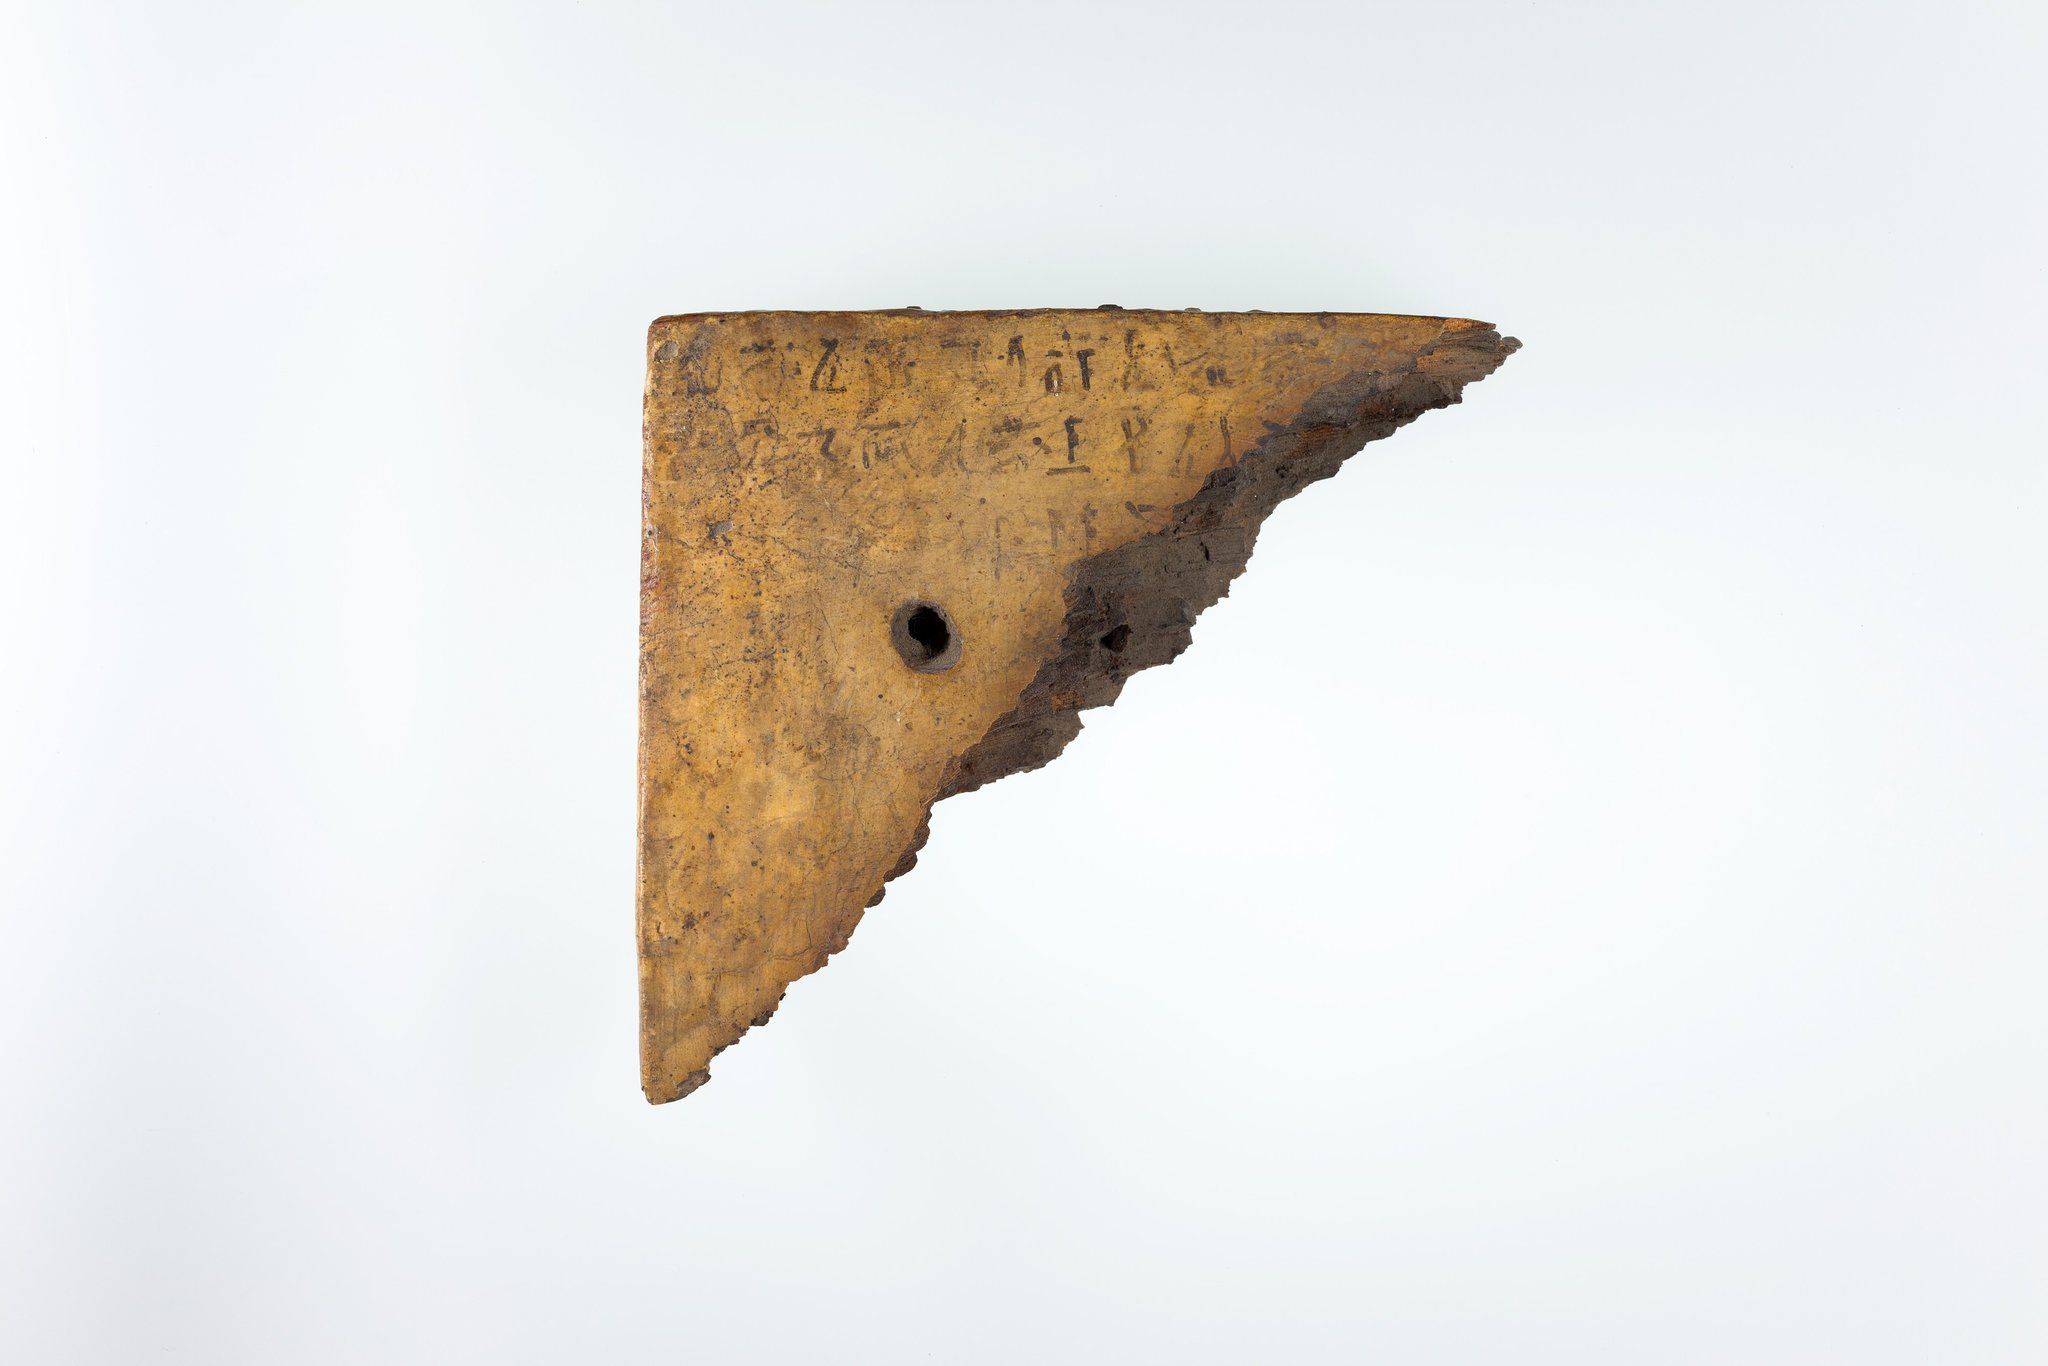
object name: writing board, sokar formula, itaseneb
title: Writing board fragment with Sokar formula for the benefit of Itaseneb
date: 2030-1981 BCE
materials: ink, plaster, wood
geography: egypt